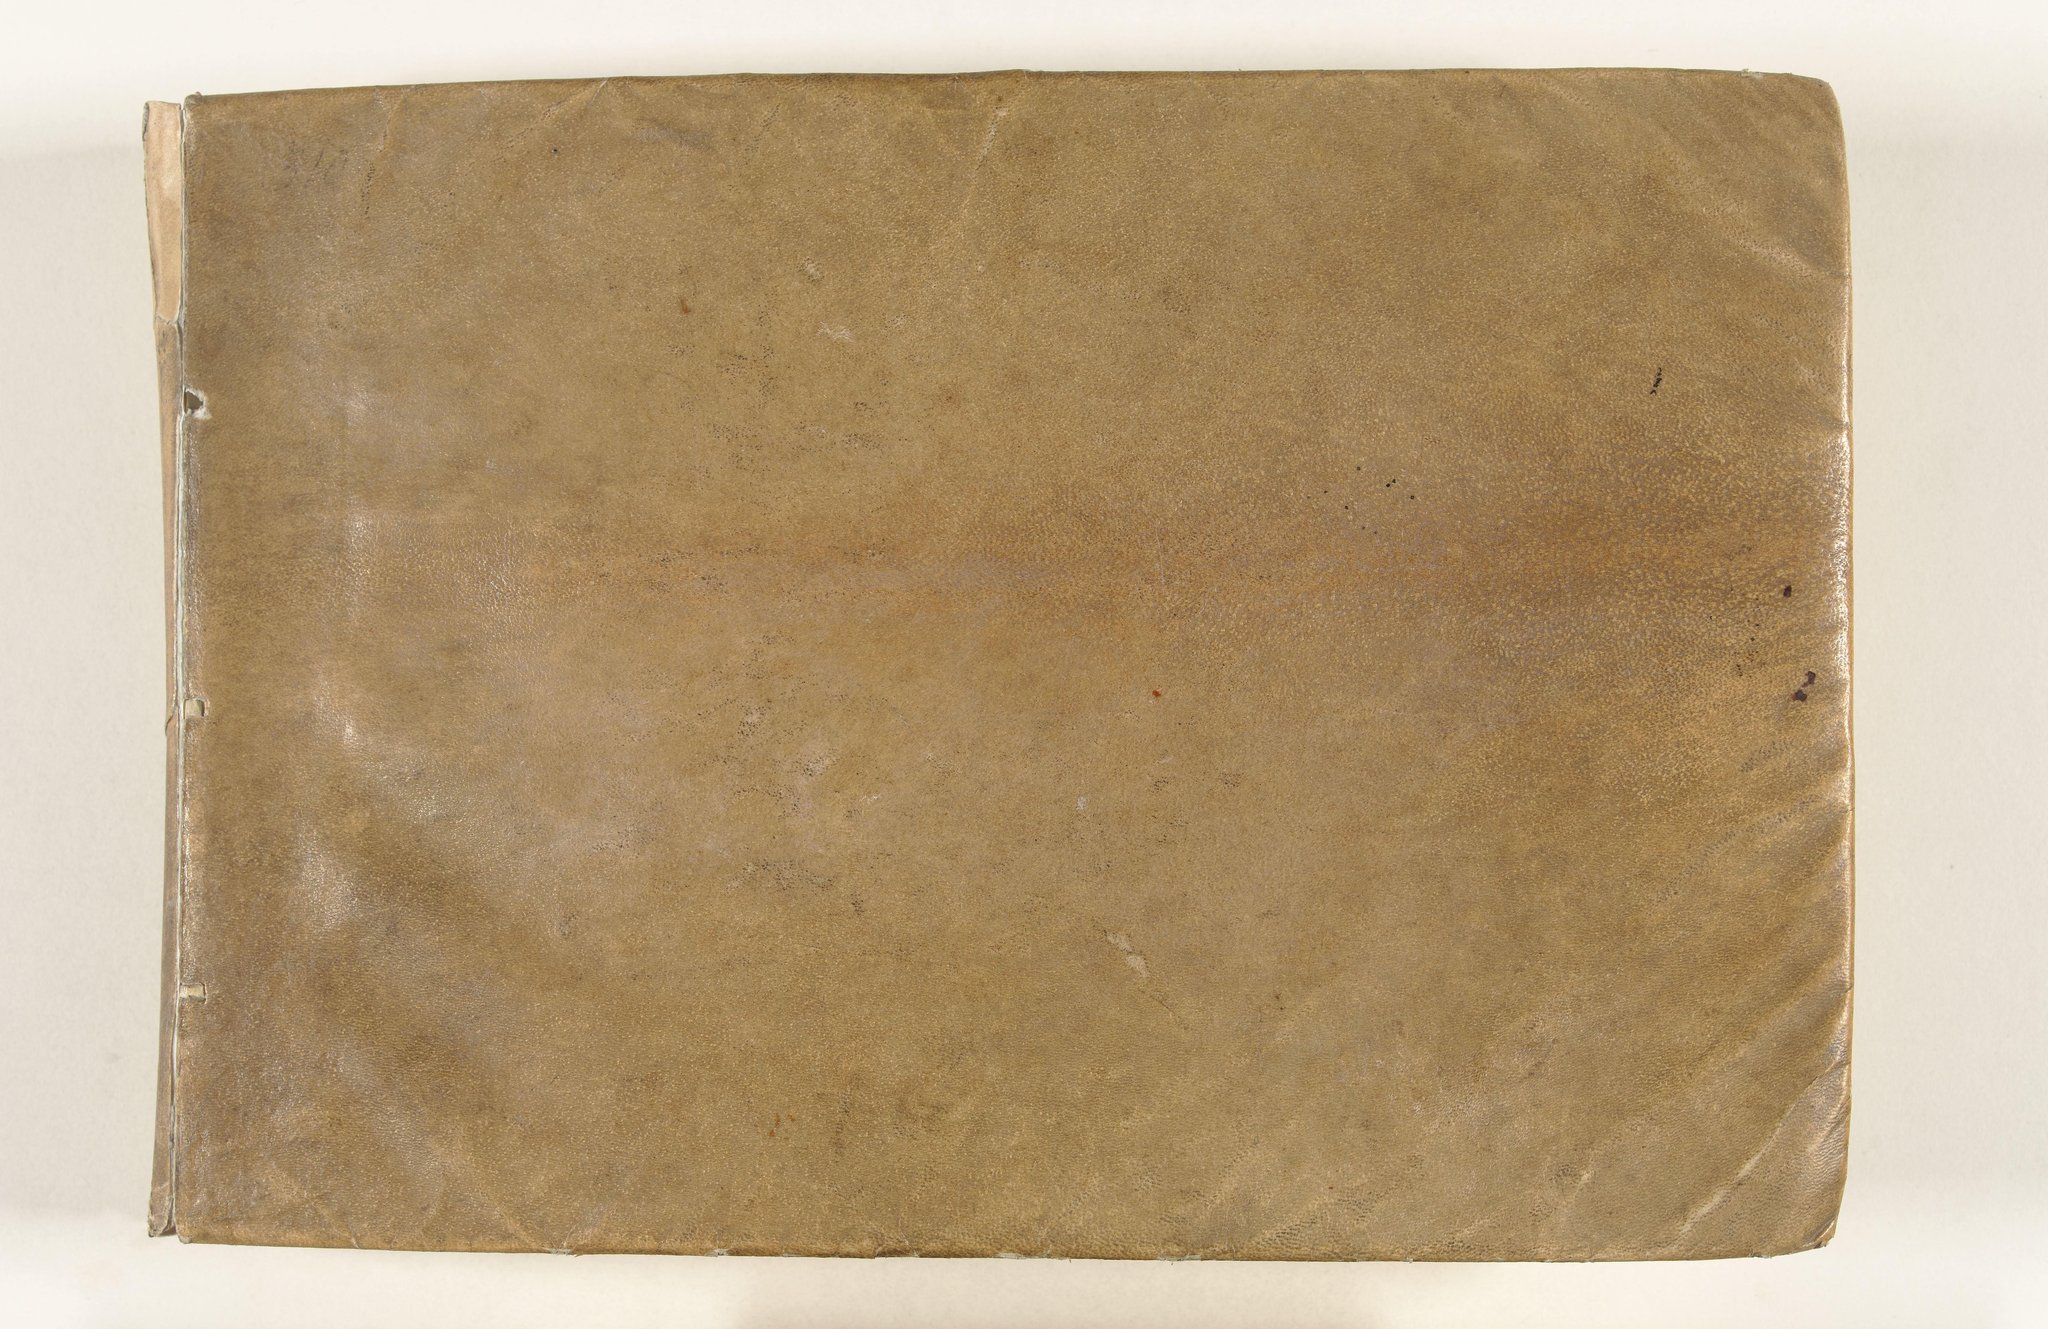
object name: album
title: The Art of Painting’s Victory over Death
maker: gesina ter borch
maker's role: draughtsman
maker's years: 1633-1690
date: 1660-1687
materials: paper, parchment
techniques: bookbinding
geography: zwolle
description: The art of painting is personified by an artist seated at her easel. The band covering her mouth underscores the silence required for the act of creation. Without looking up from her work, she tramples Time with his fallen scythe and Death, whose snapped arrow cannot harm her. The message here is clear: art is eternal, life is not.